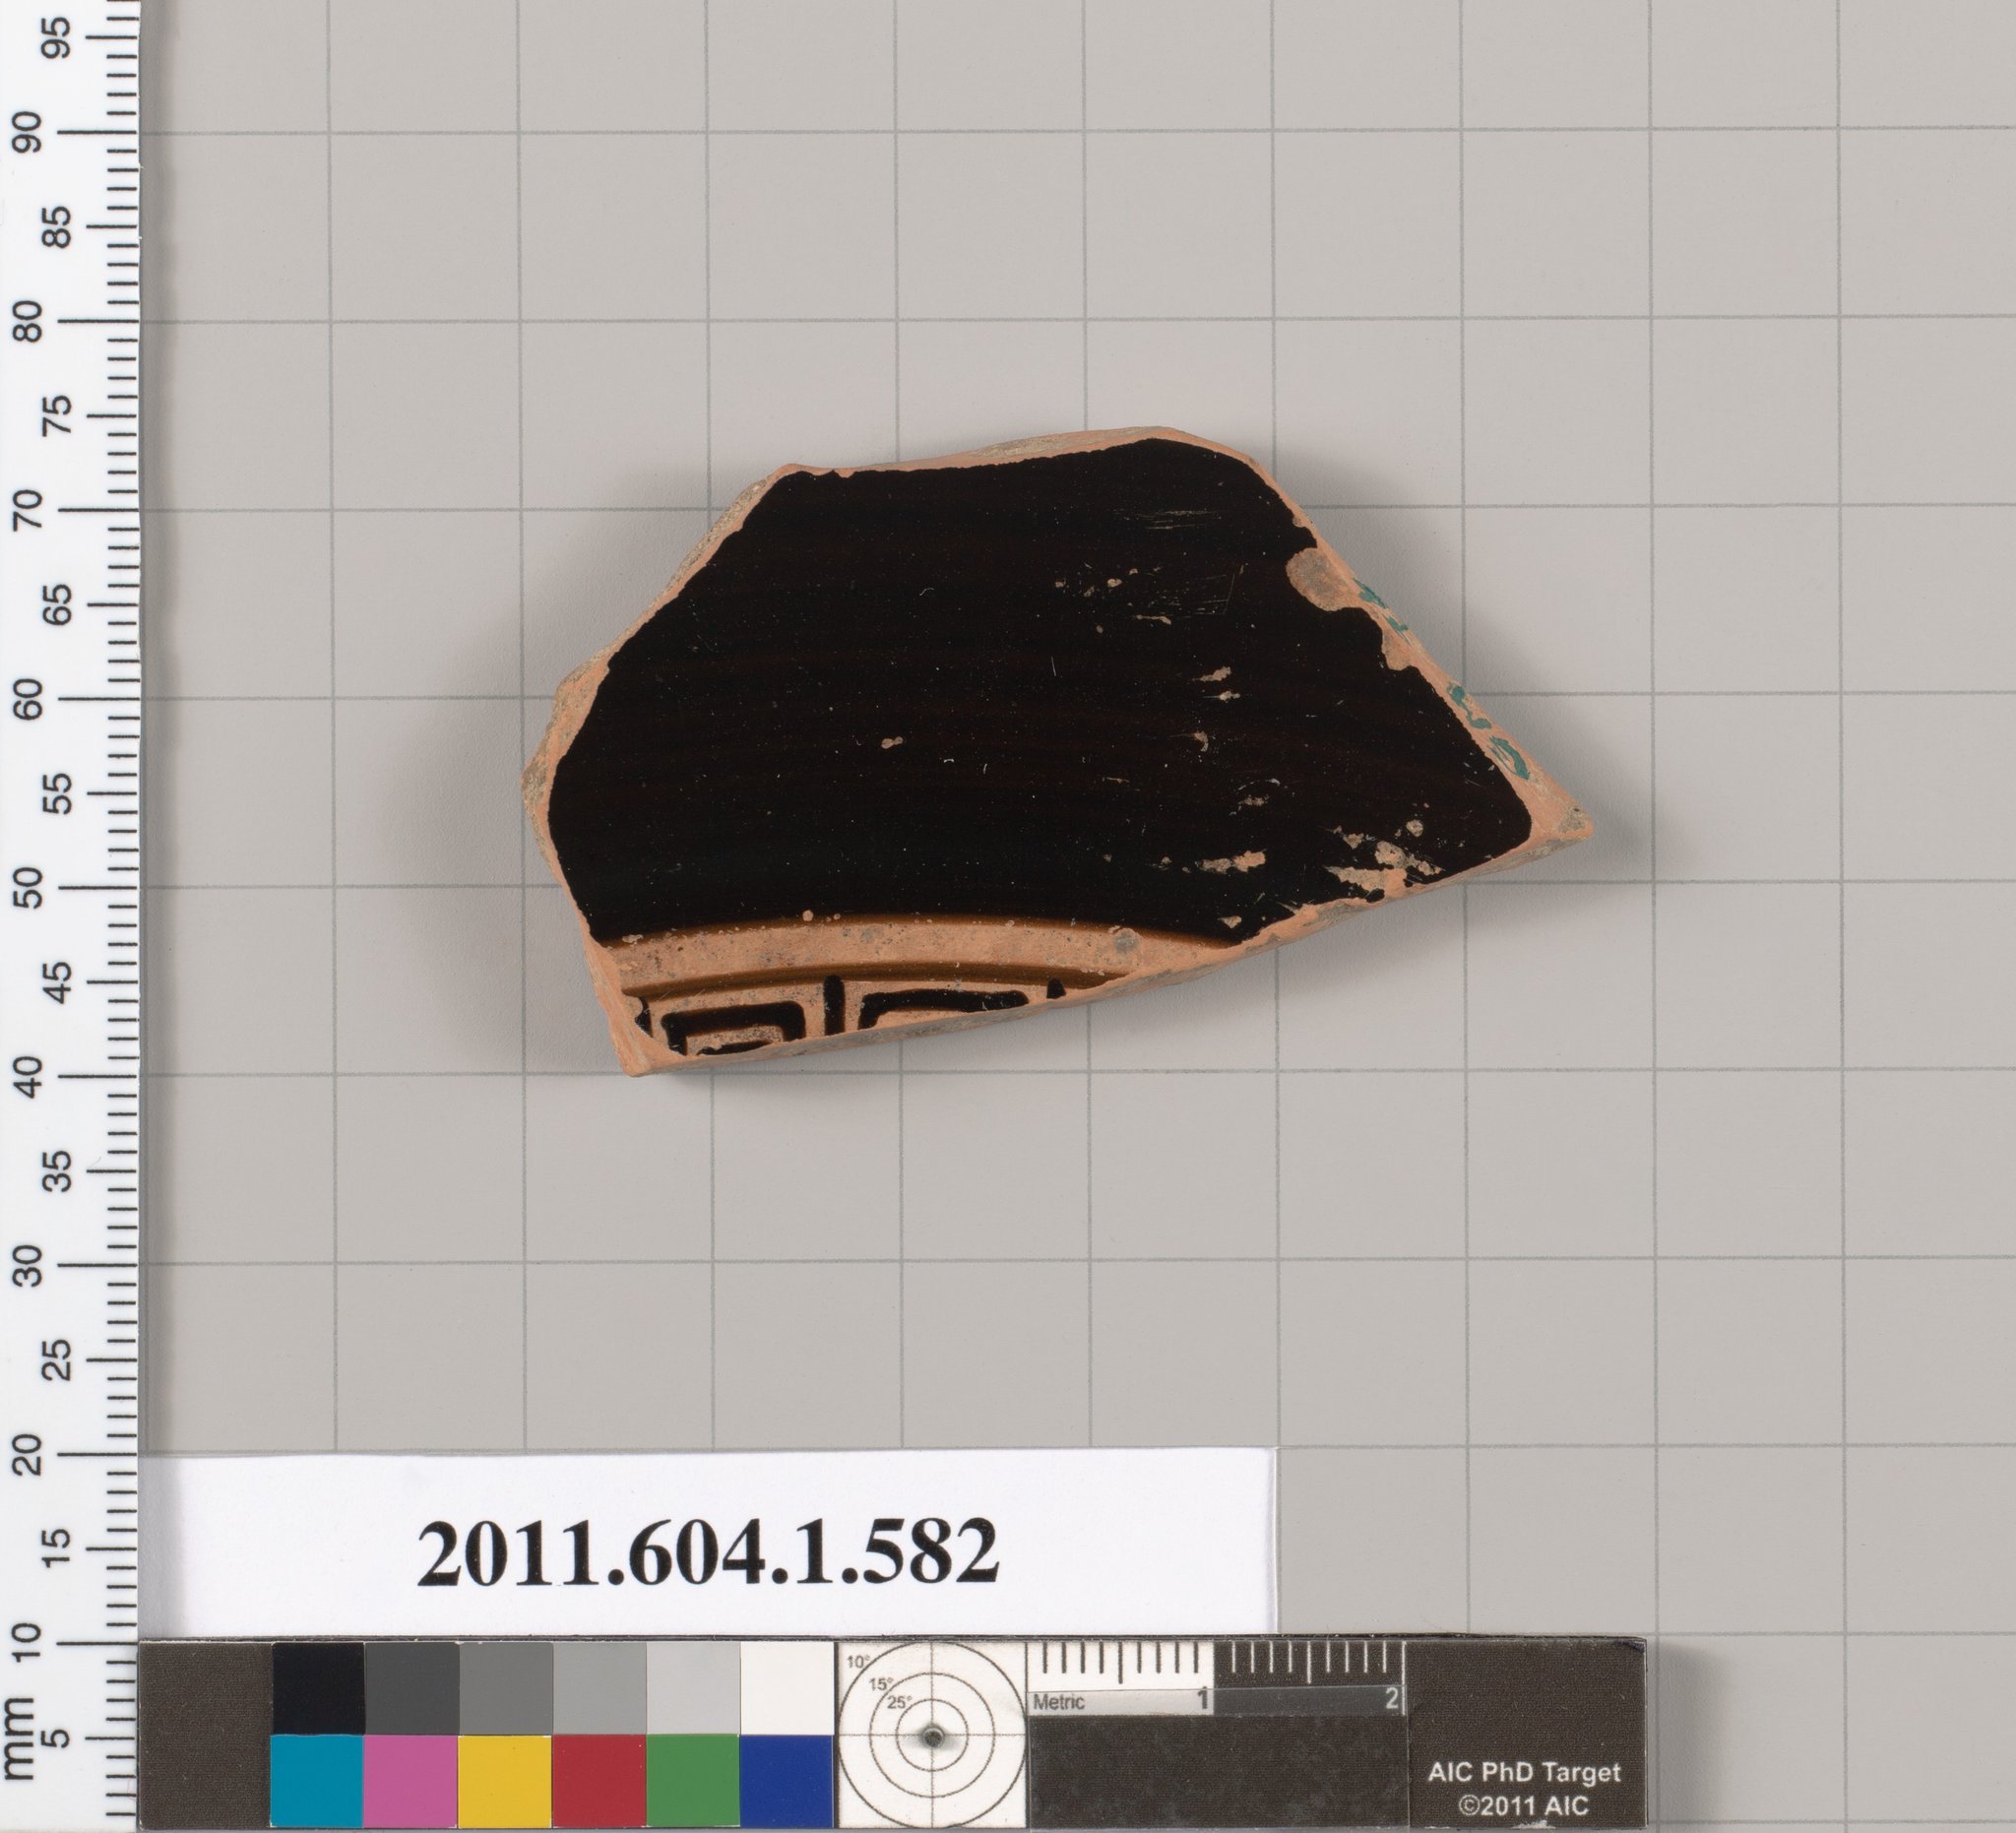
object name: kylix fragment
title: Terracotta fragment of a kylix (drinking cup)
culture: greek, attic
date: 500-468 BCE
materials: terracotta